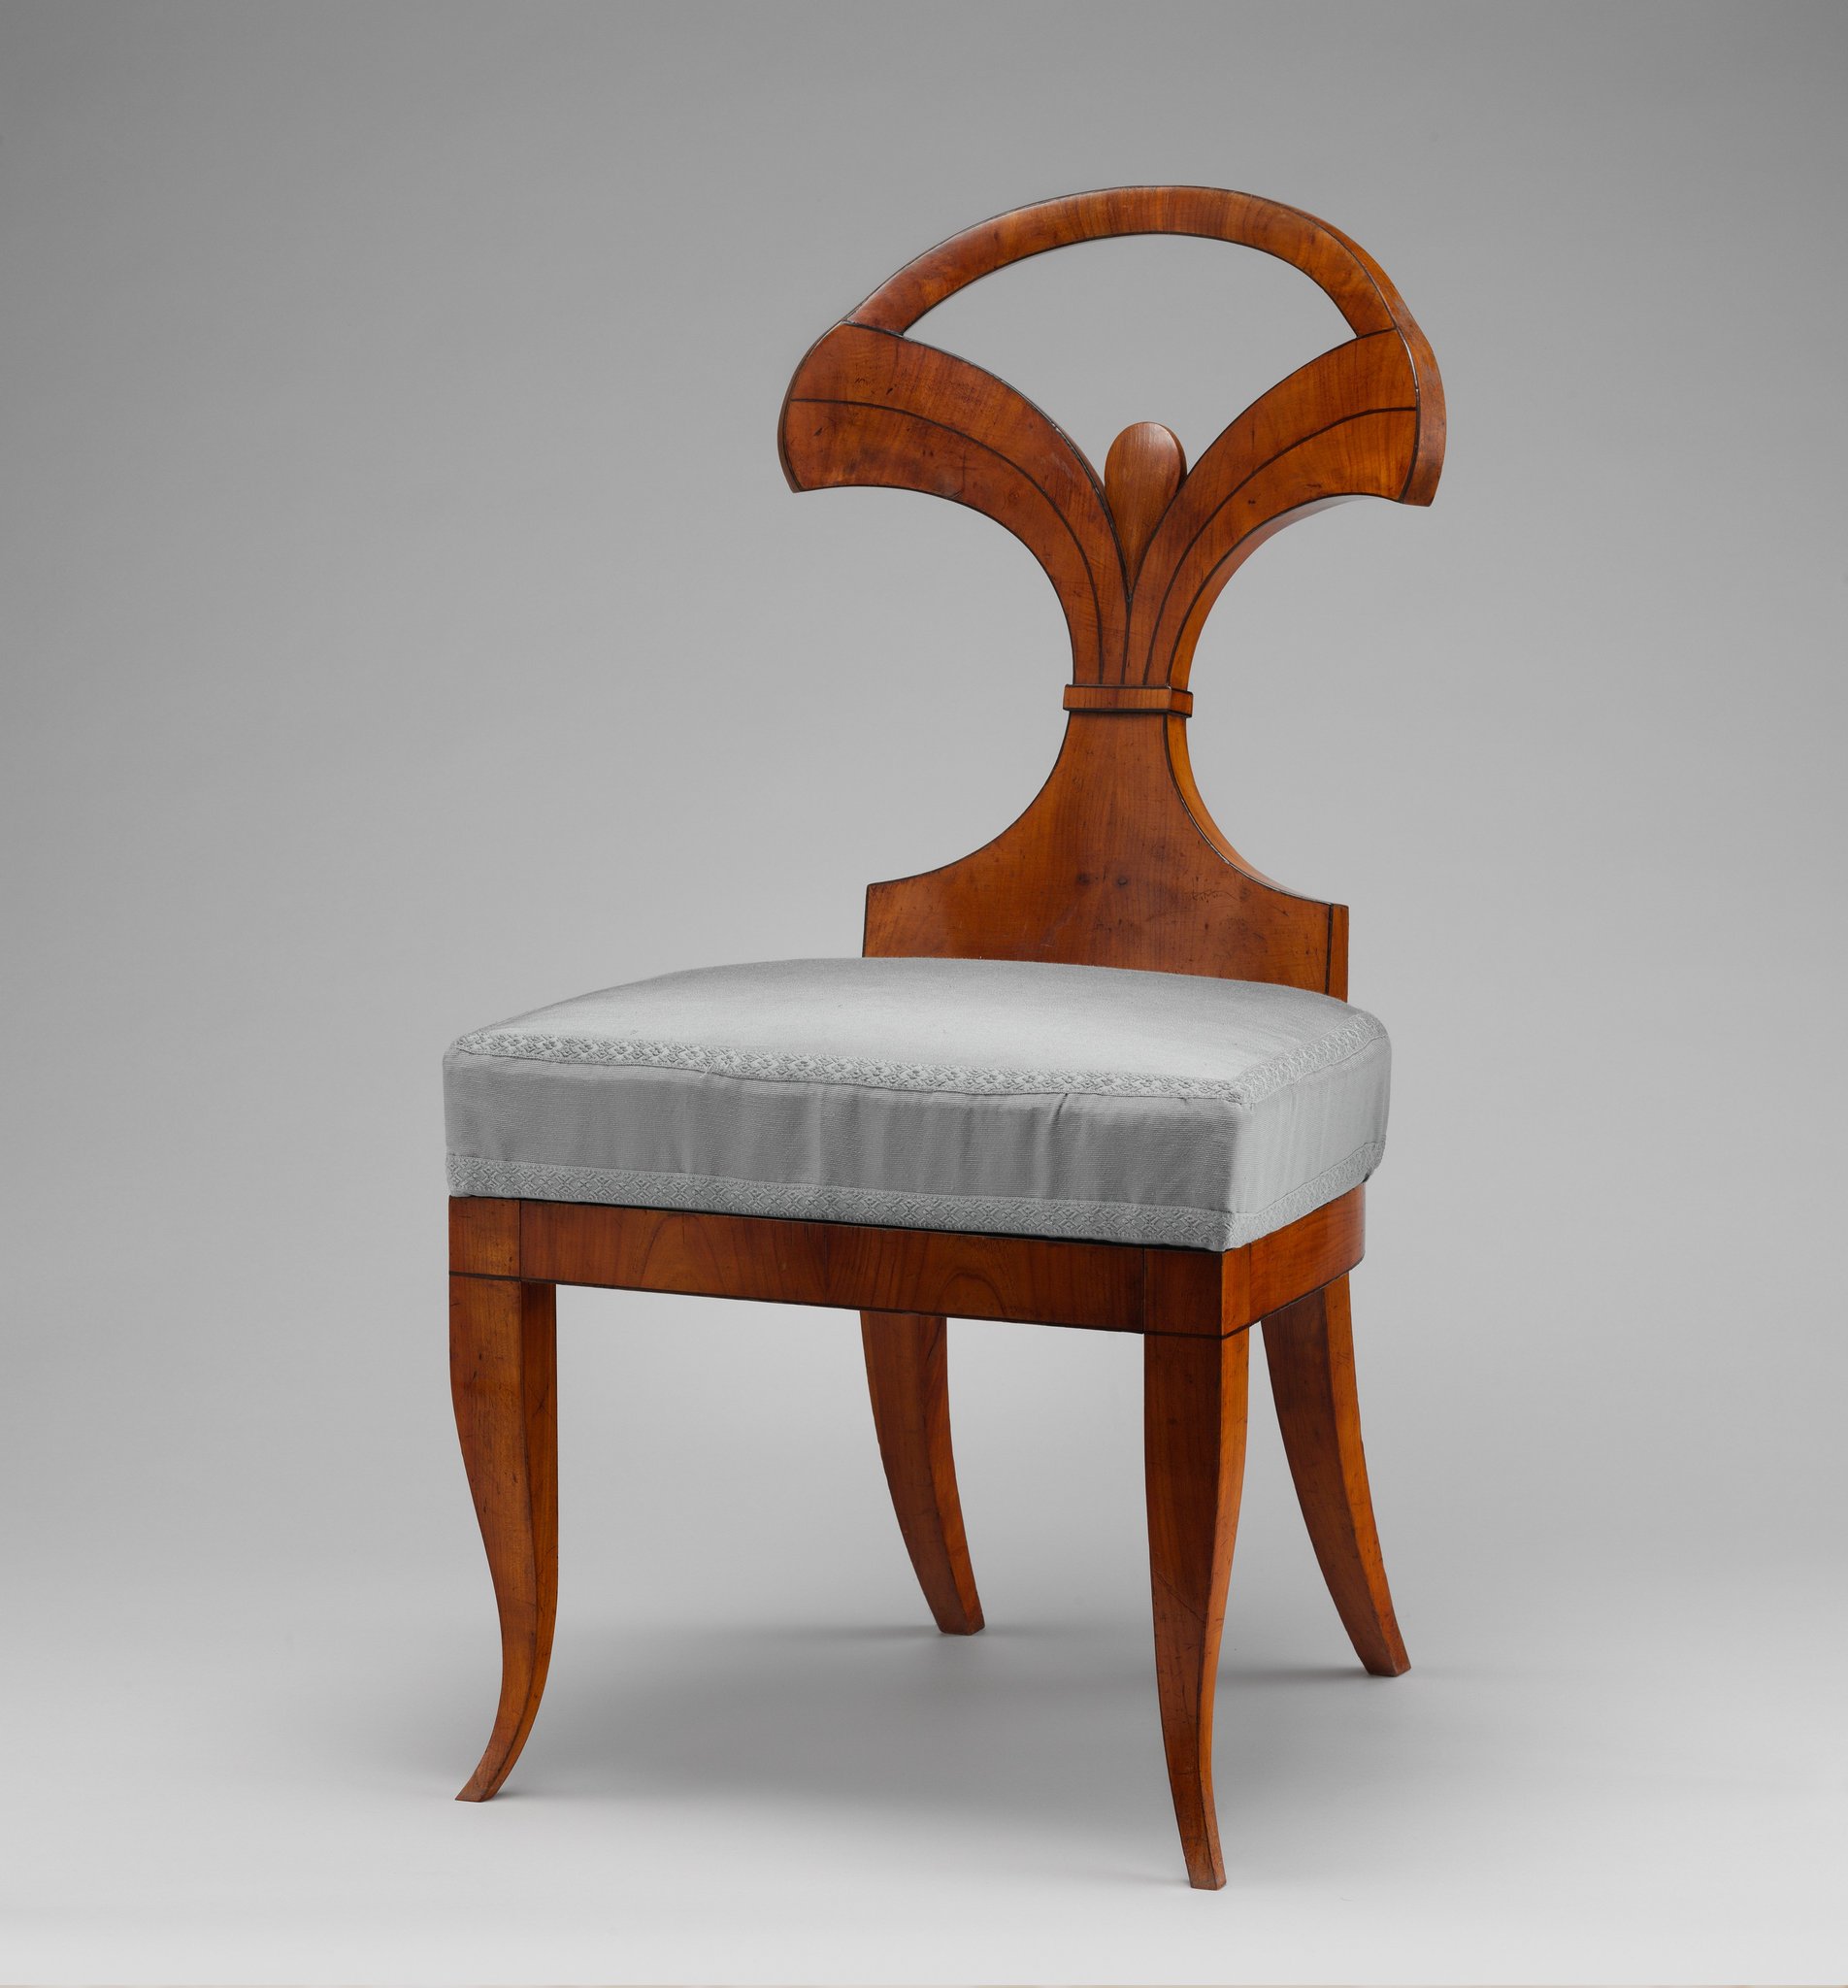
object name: side chair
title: Side chair (one of a pair)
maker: josef danhauser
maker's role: maker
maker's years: 1780-1829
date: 1815-1820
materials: wood, silk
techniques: veneering